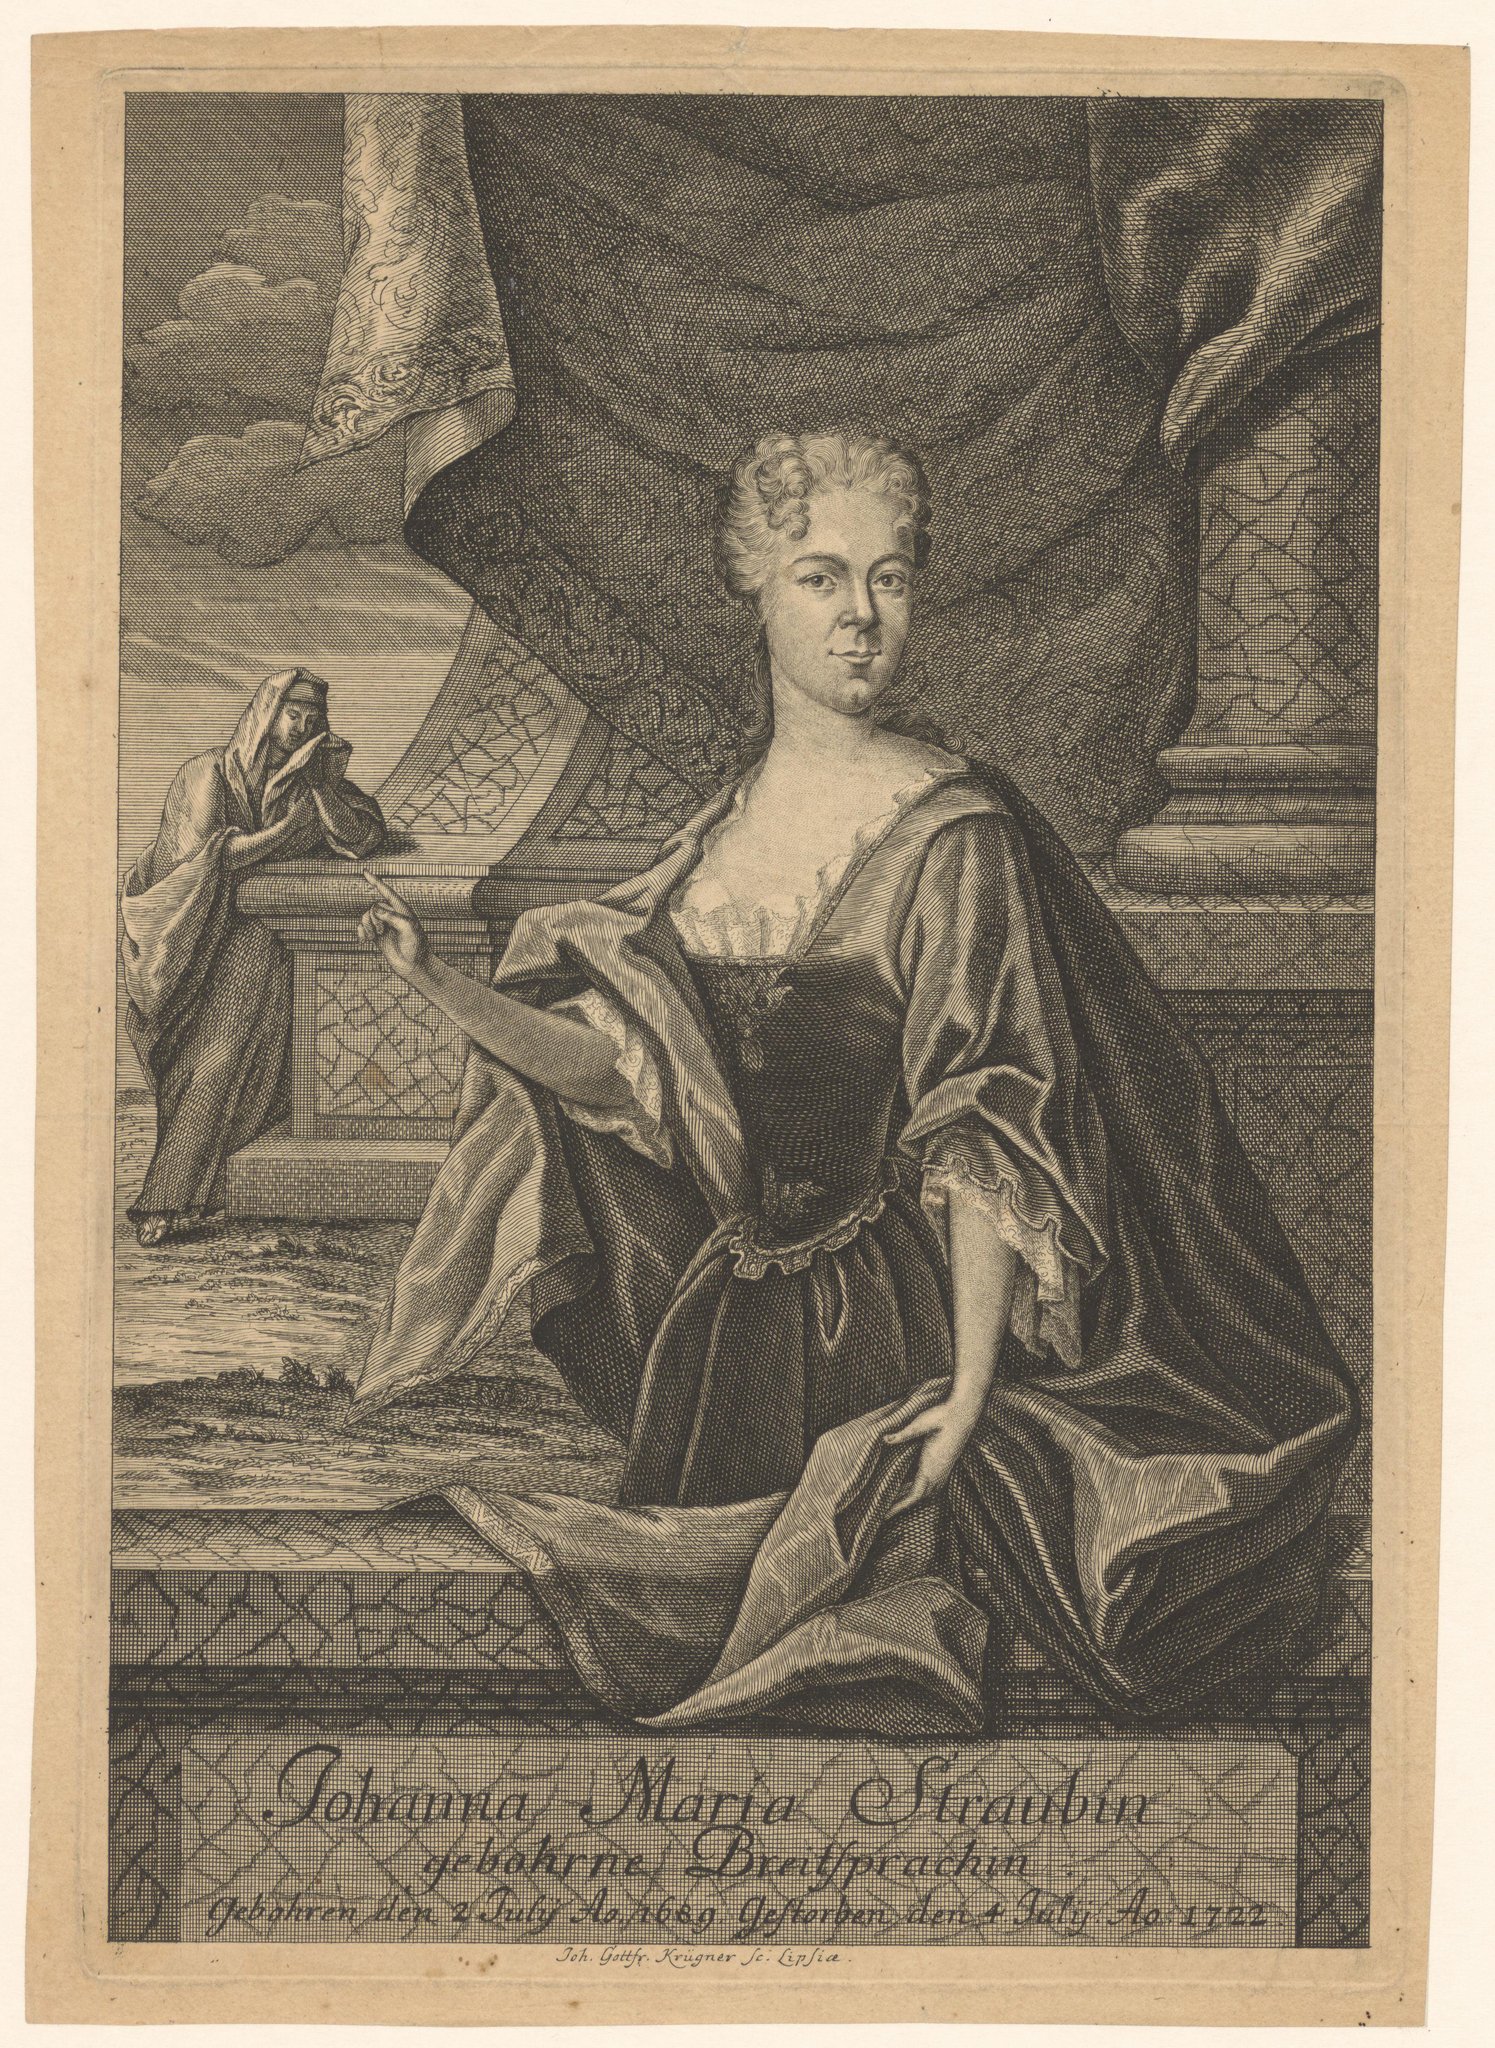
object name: print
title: Portret van Johanna Maria Straub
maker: johann gottfried krügner (i)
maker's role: artist, print maker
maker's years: 1684-1769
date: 1722-1769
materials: paper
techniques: engraving, etching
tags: historical persons, ornament derived from architectural details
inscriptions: collector's mark: Lugt 358, collector's mark: Lugt 2228